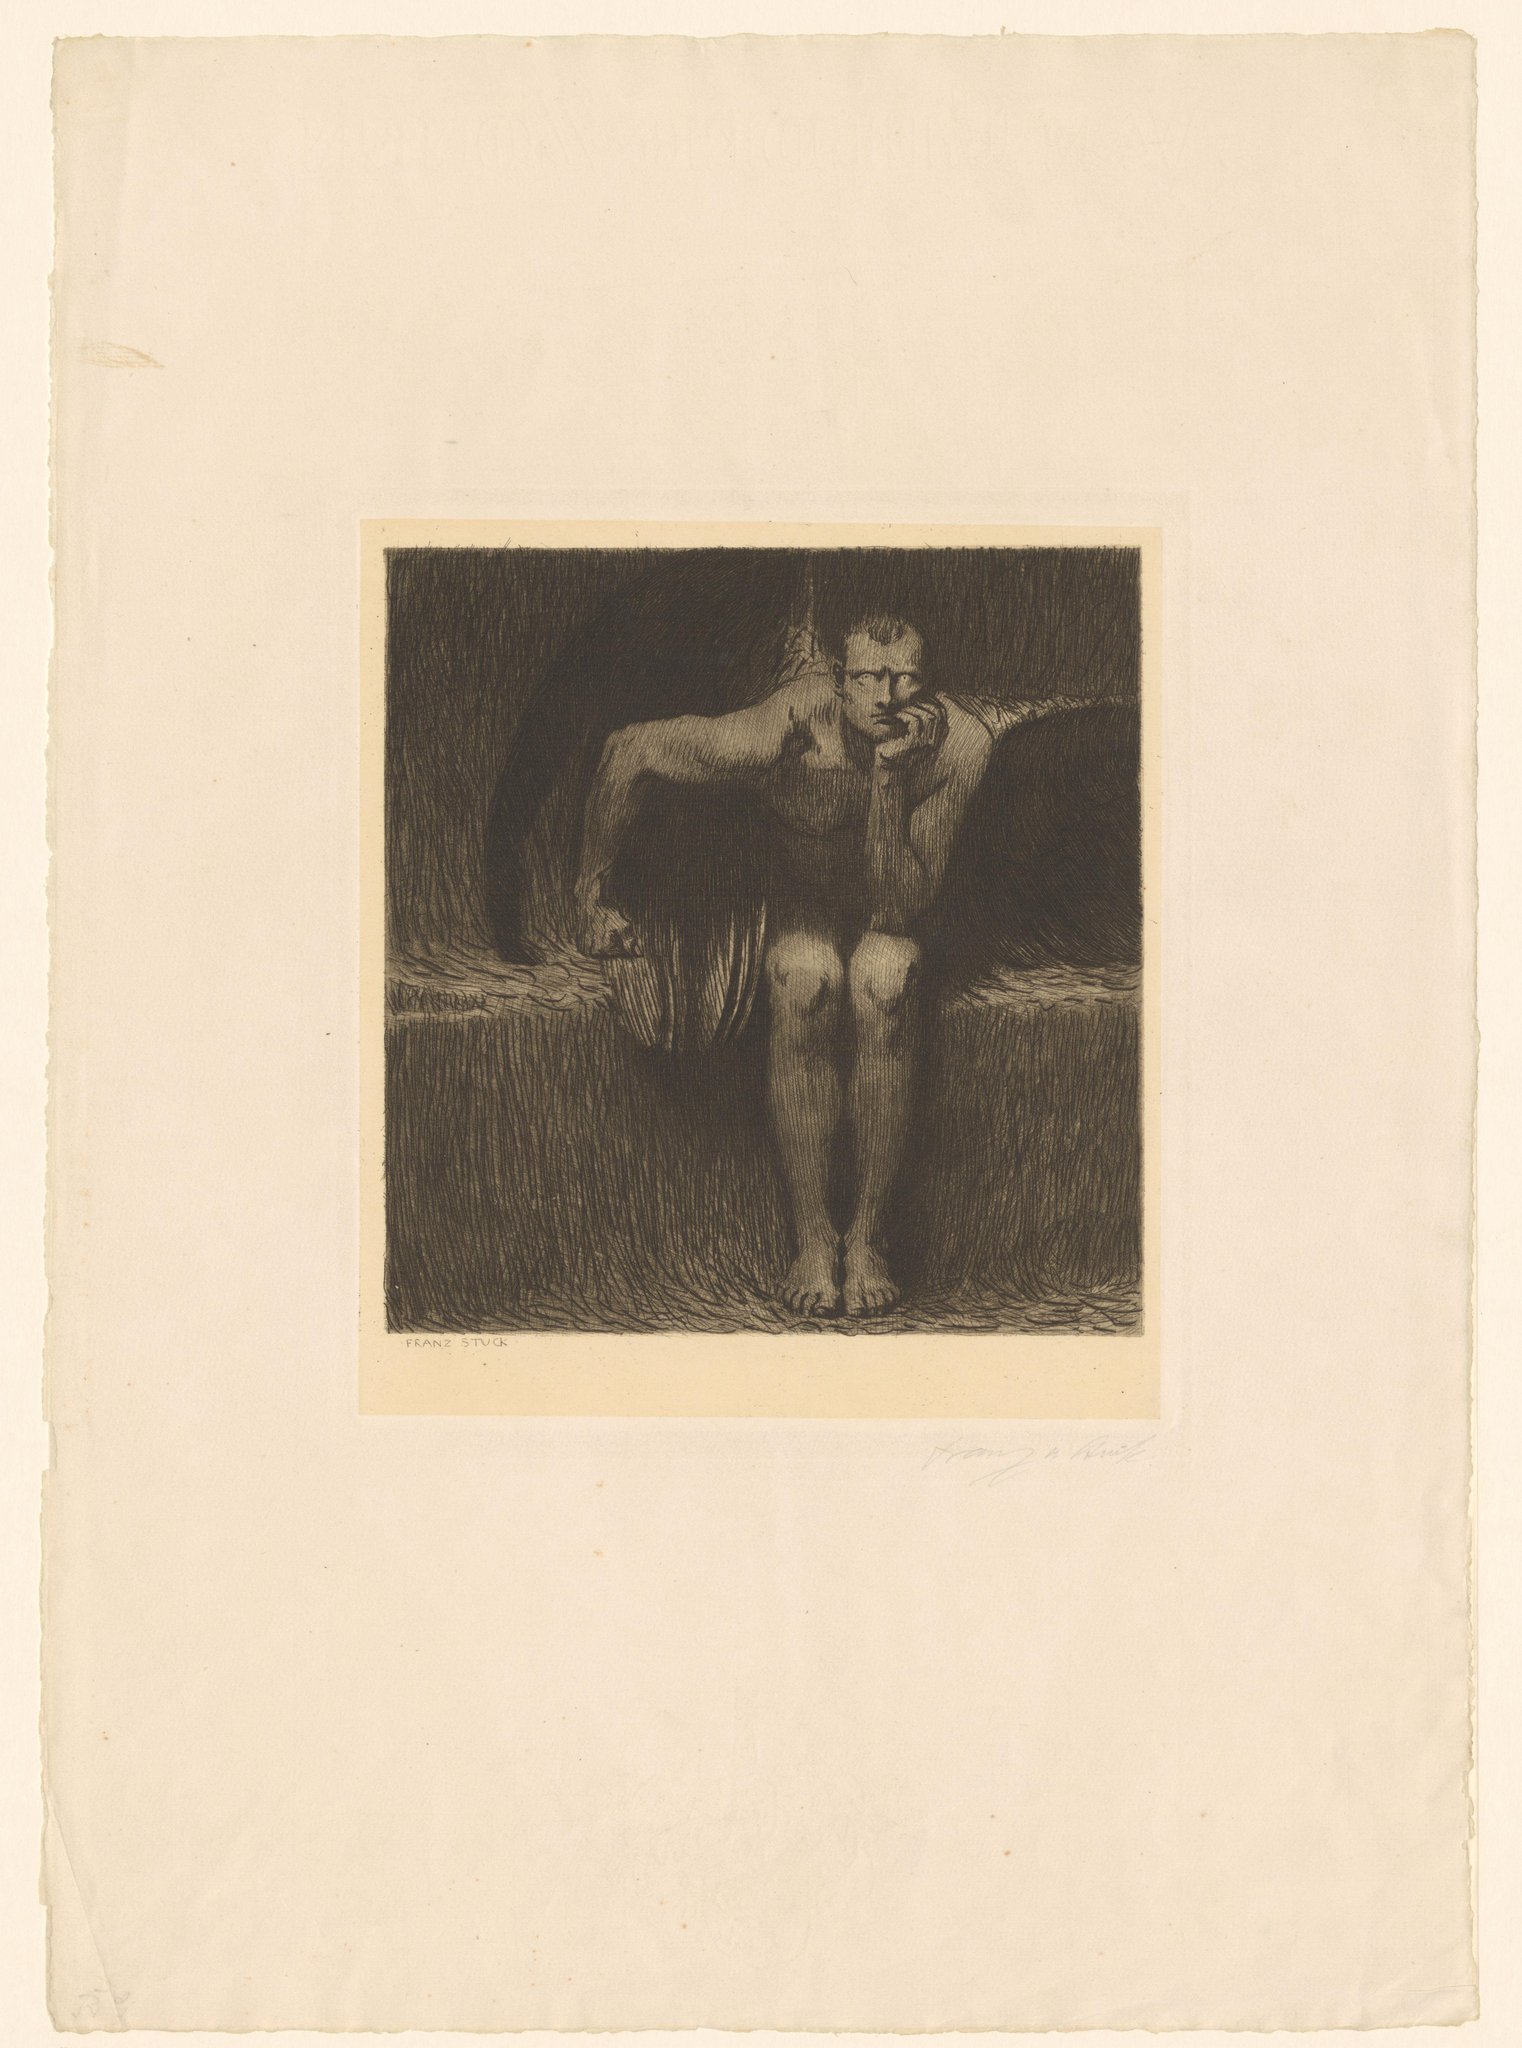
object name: print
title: Lucifer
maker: franz von stuck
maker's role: draughtsman, painter, print maker, sculptor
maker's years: 1862-1928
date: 1890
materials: paper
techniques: drypoint, etching, intaglio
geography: germany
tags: human-shaped devil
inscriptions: collector's mark: Lugt 2228